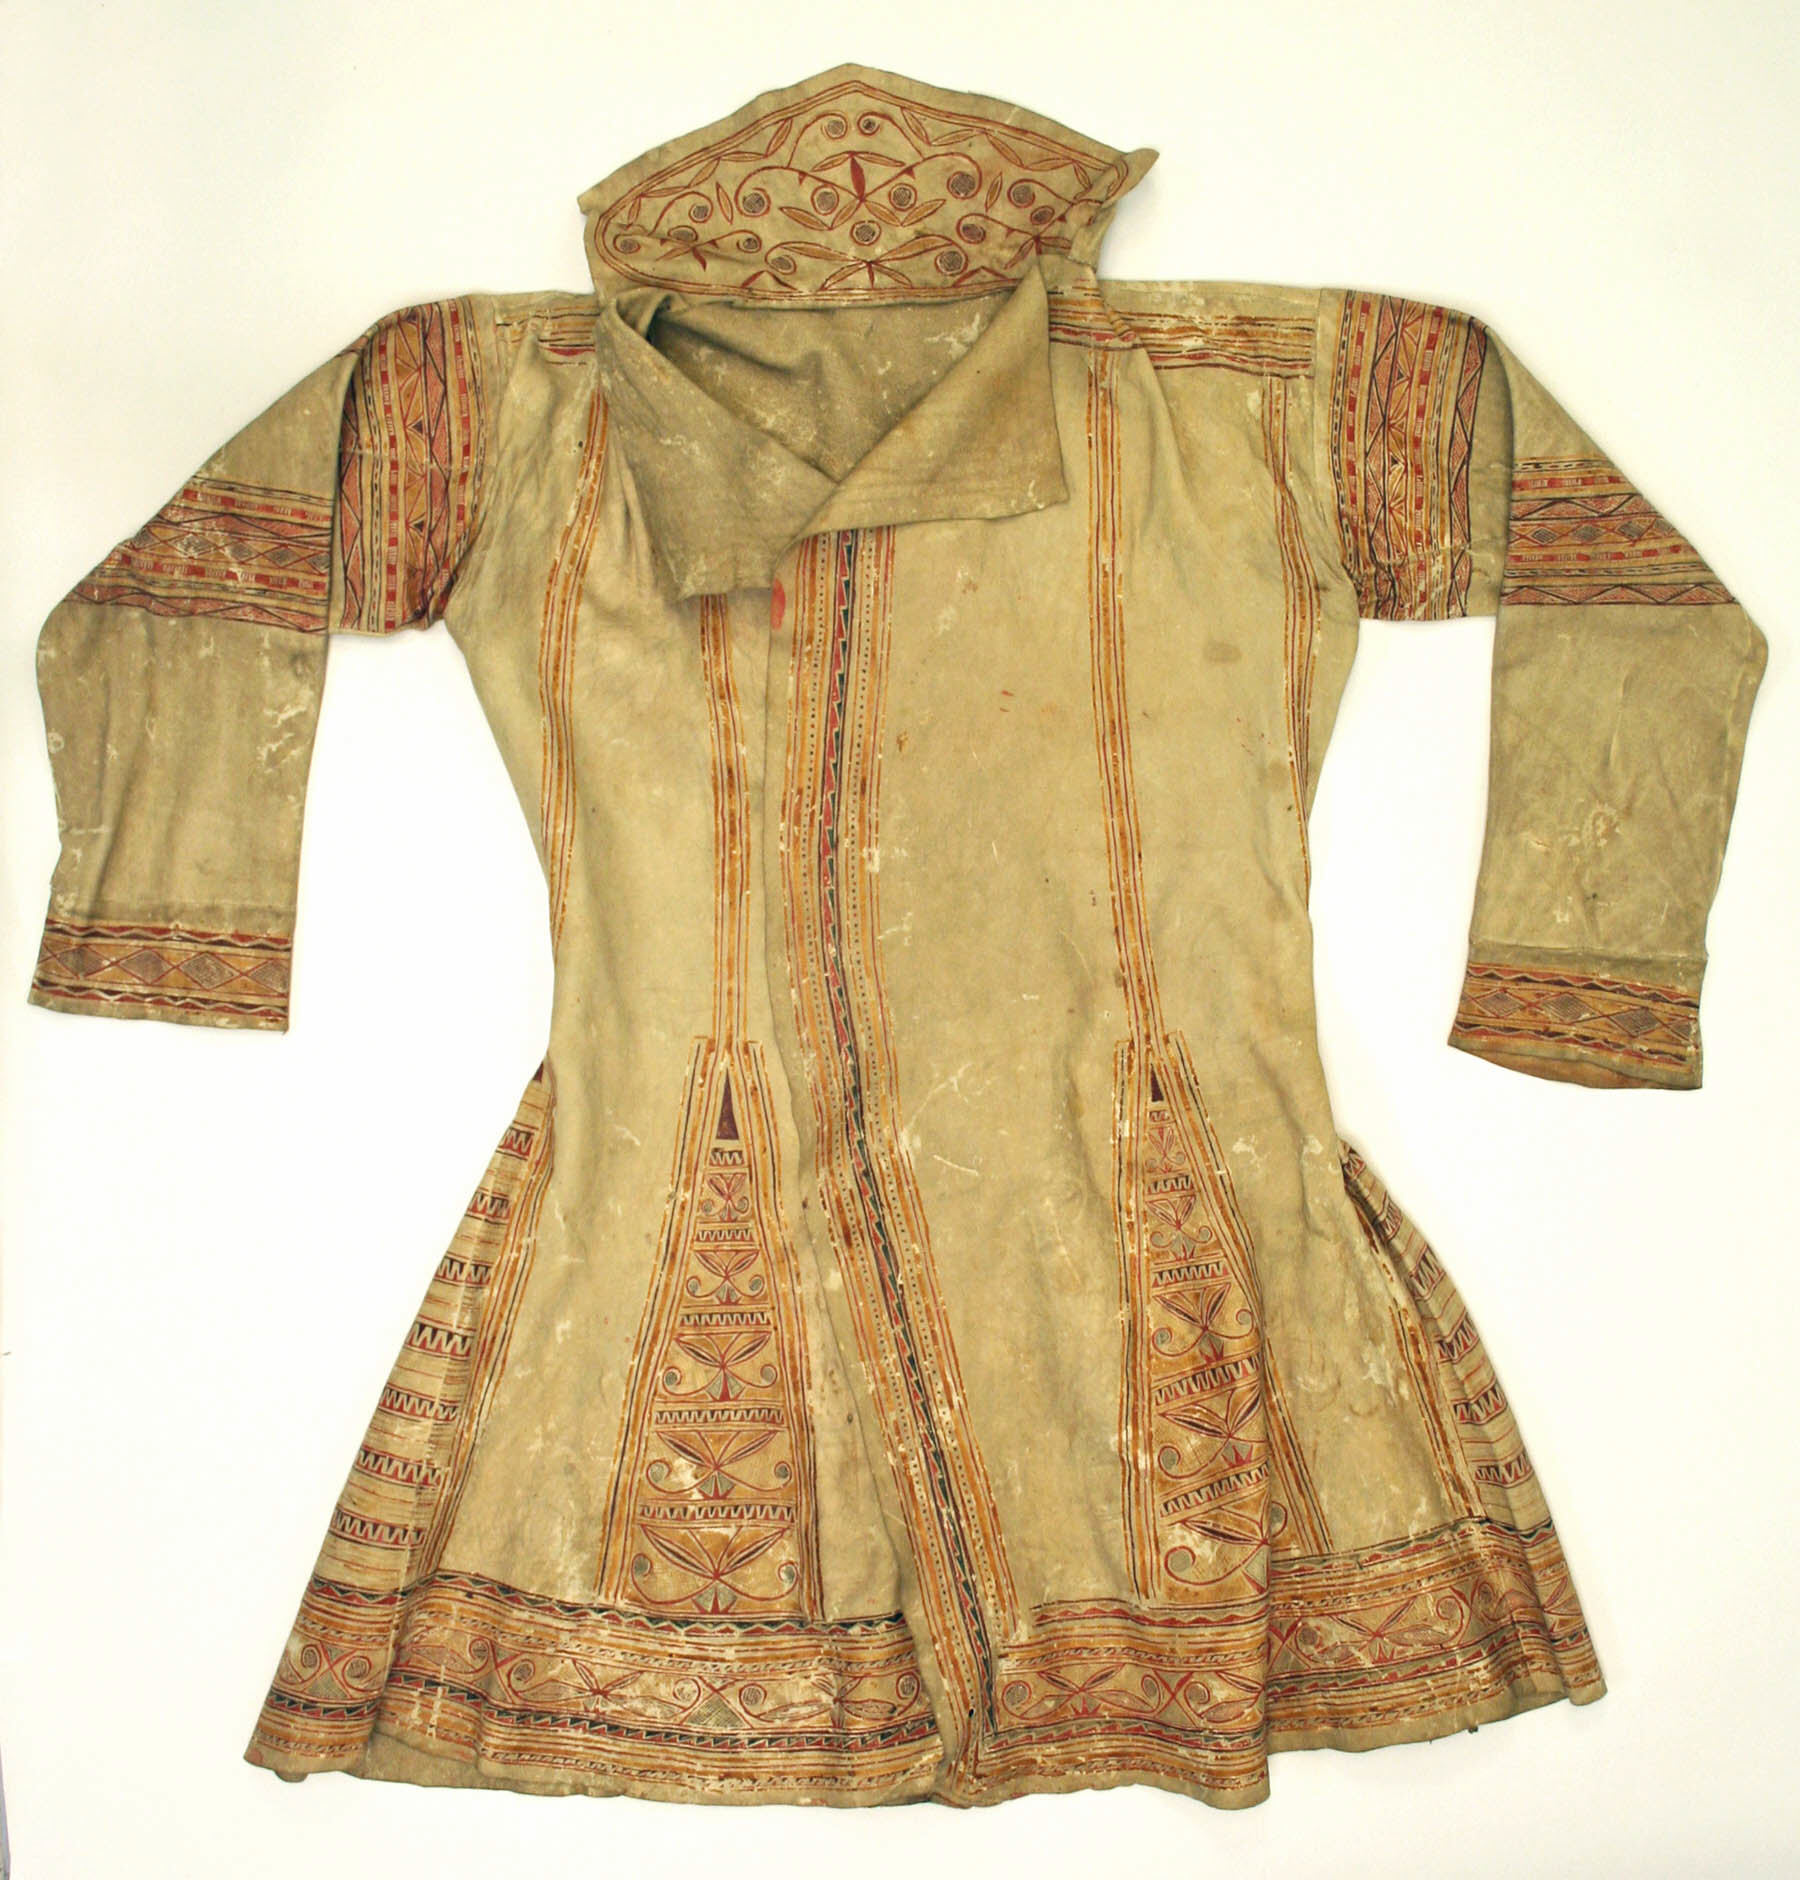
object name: ensemble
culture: innu or naskapi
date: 1820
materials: leather, pigment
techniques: tanning